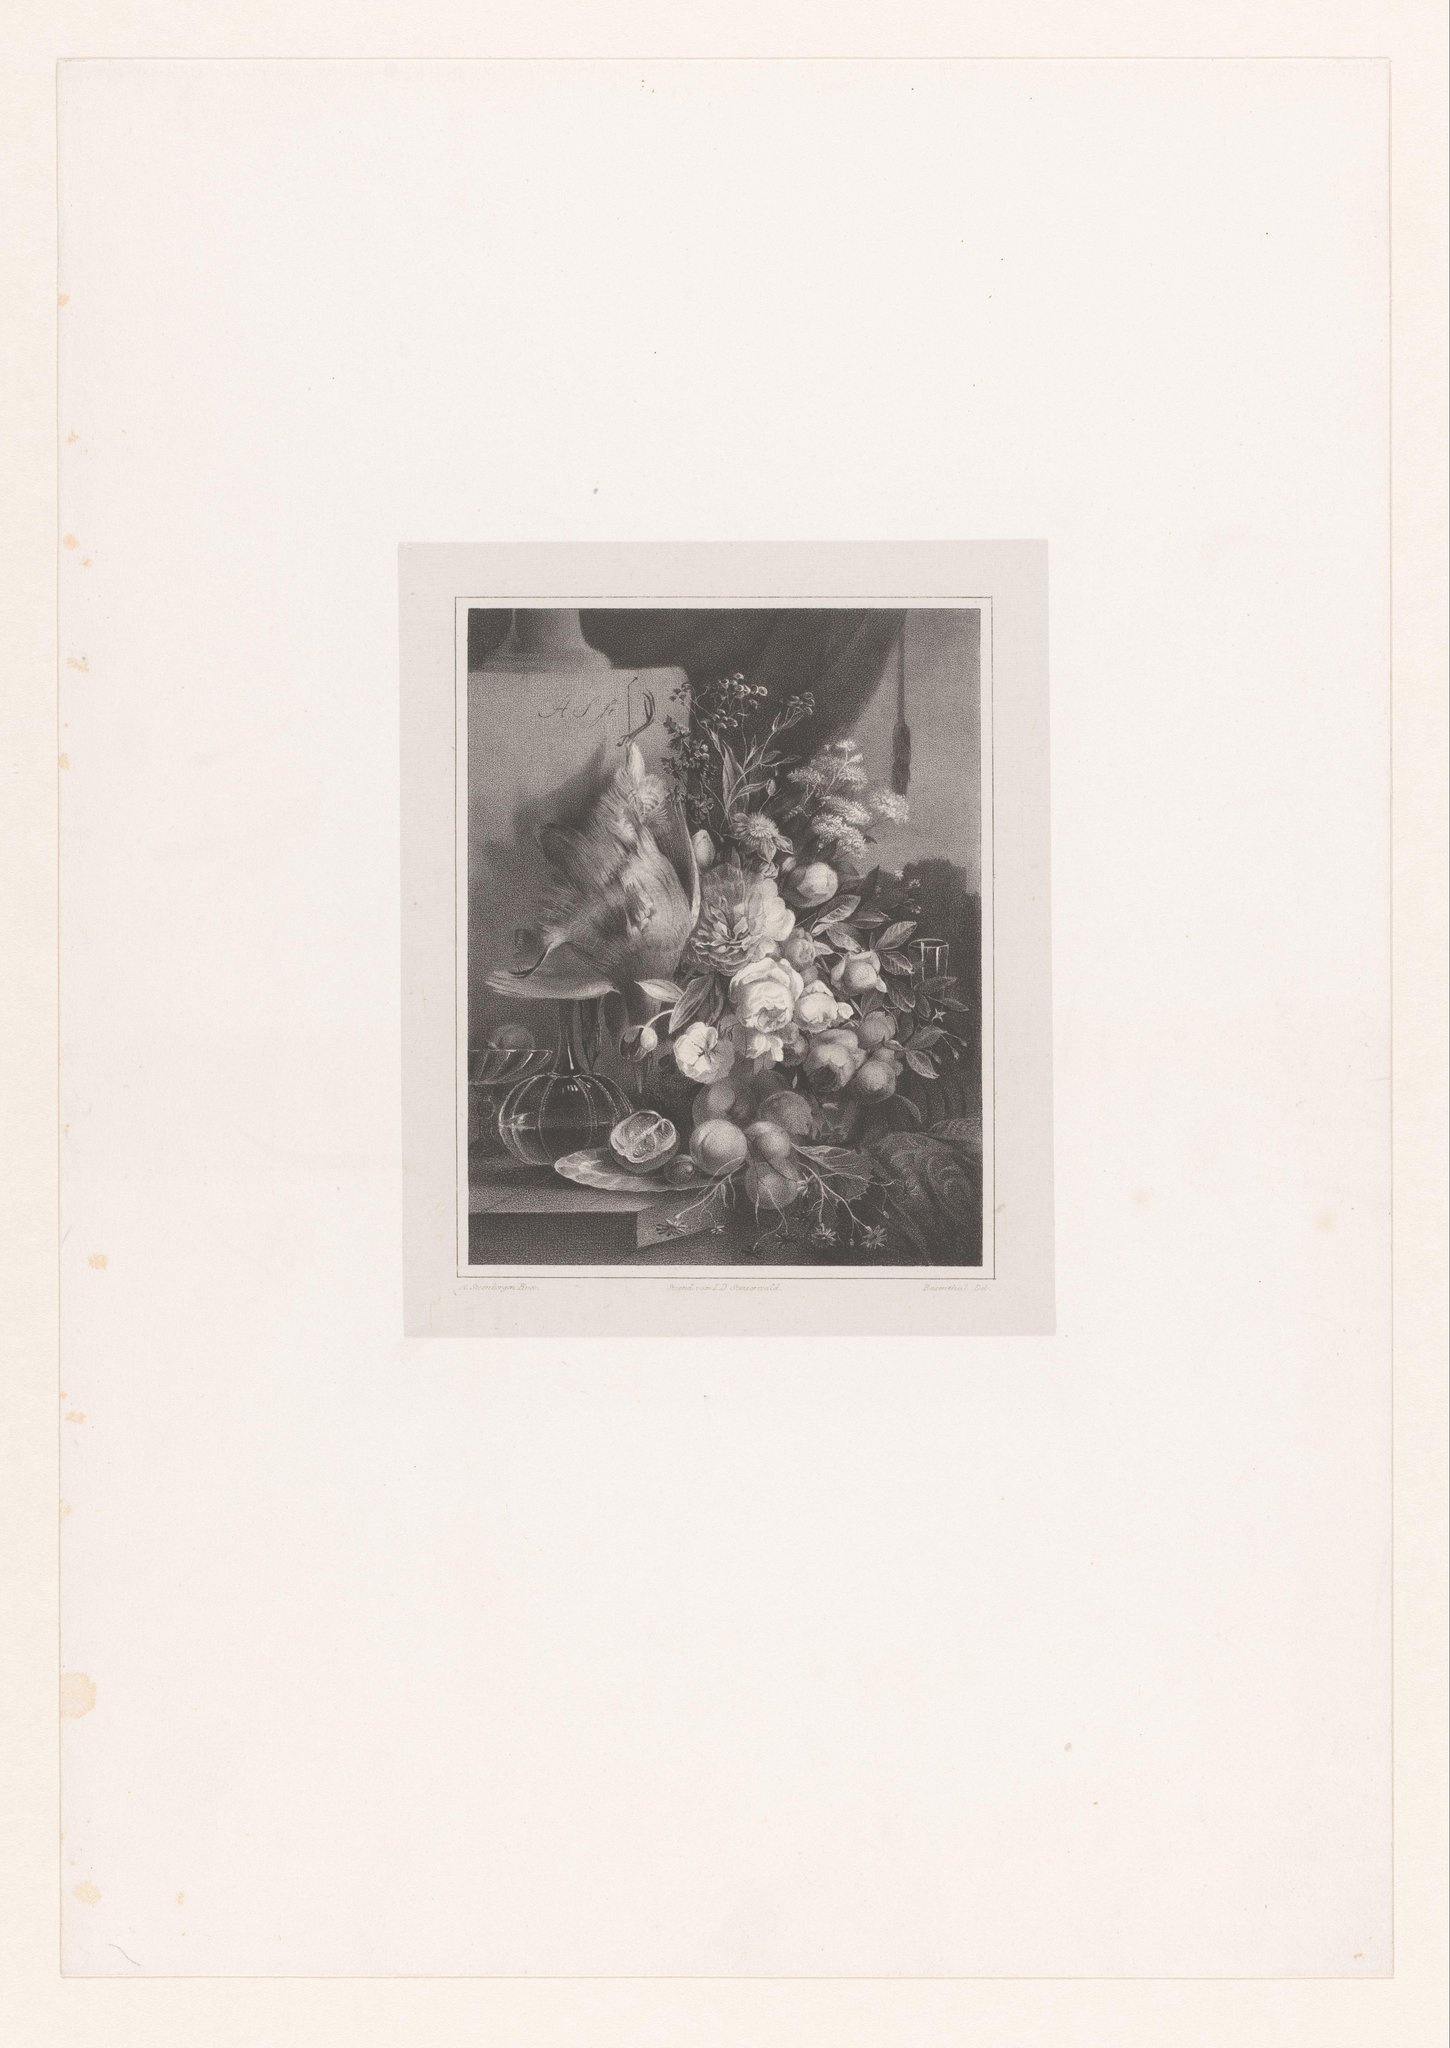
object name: print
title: Stilleven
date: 1833-1863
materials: paper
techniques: lithograph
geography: the hague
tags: cut flowers; nosegay, bunch of flowers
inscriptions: collector's mark: Lugt 2228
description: Stilleven van bloemen, vruchten, een patrijs en een wijnfles.